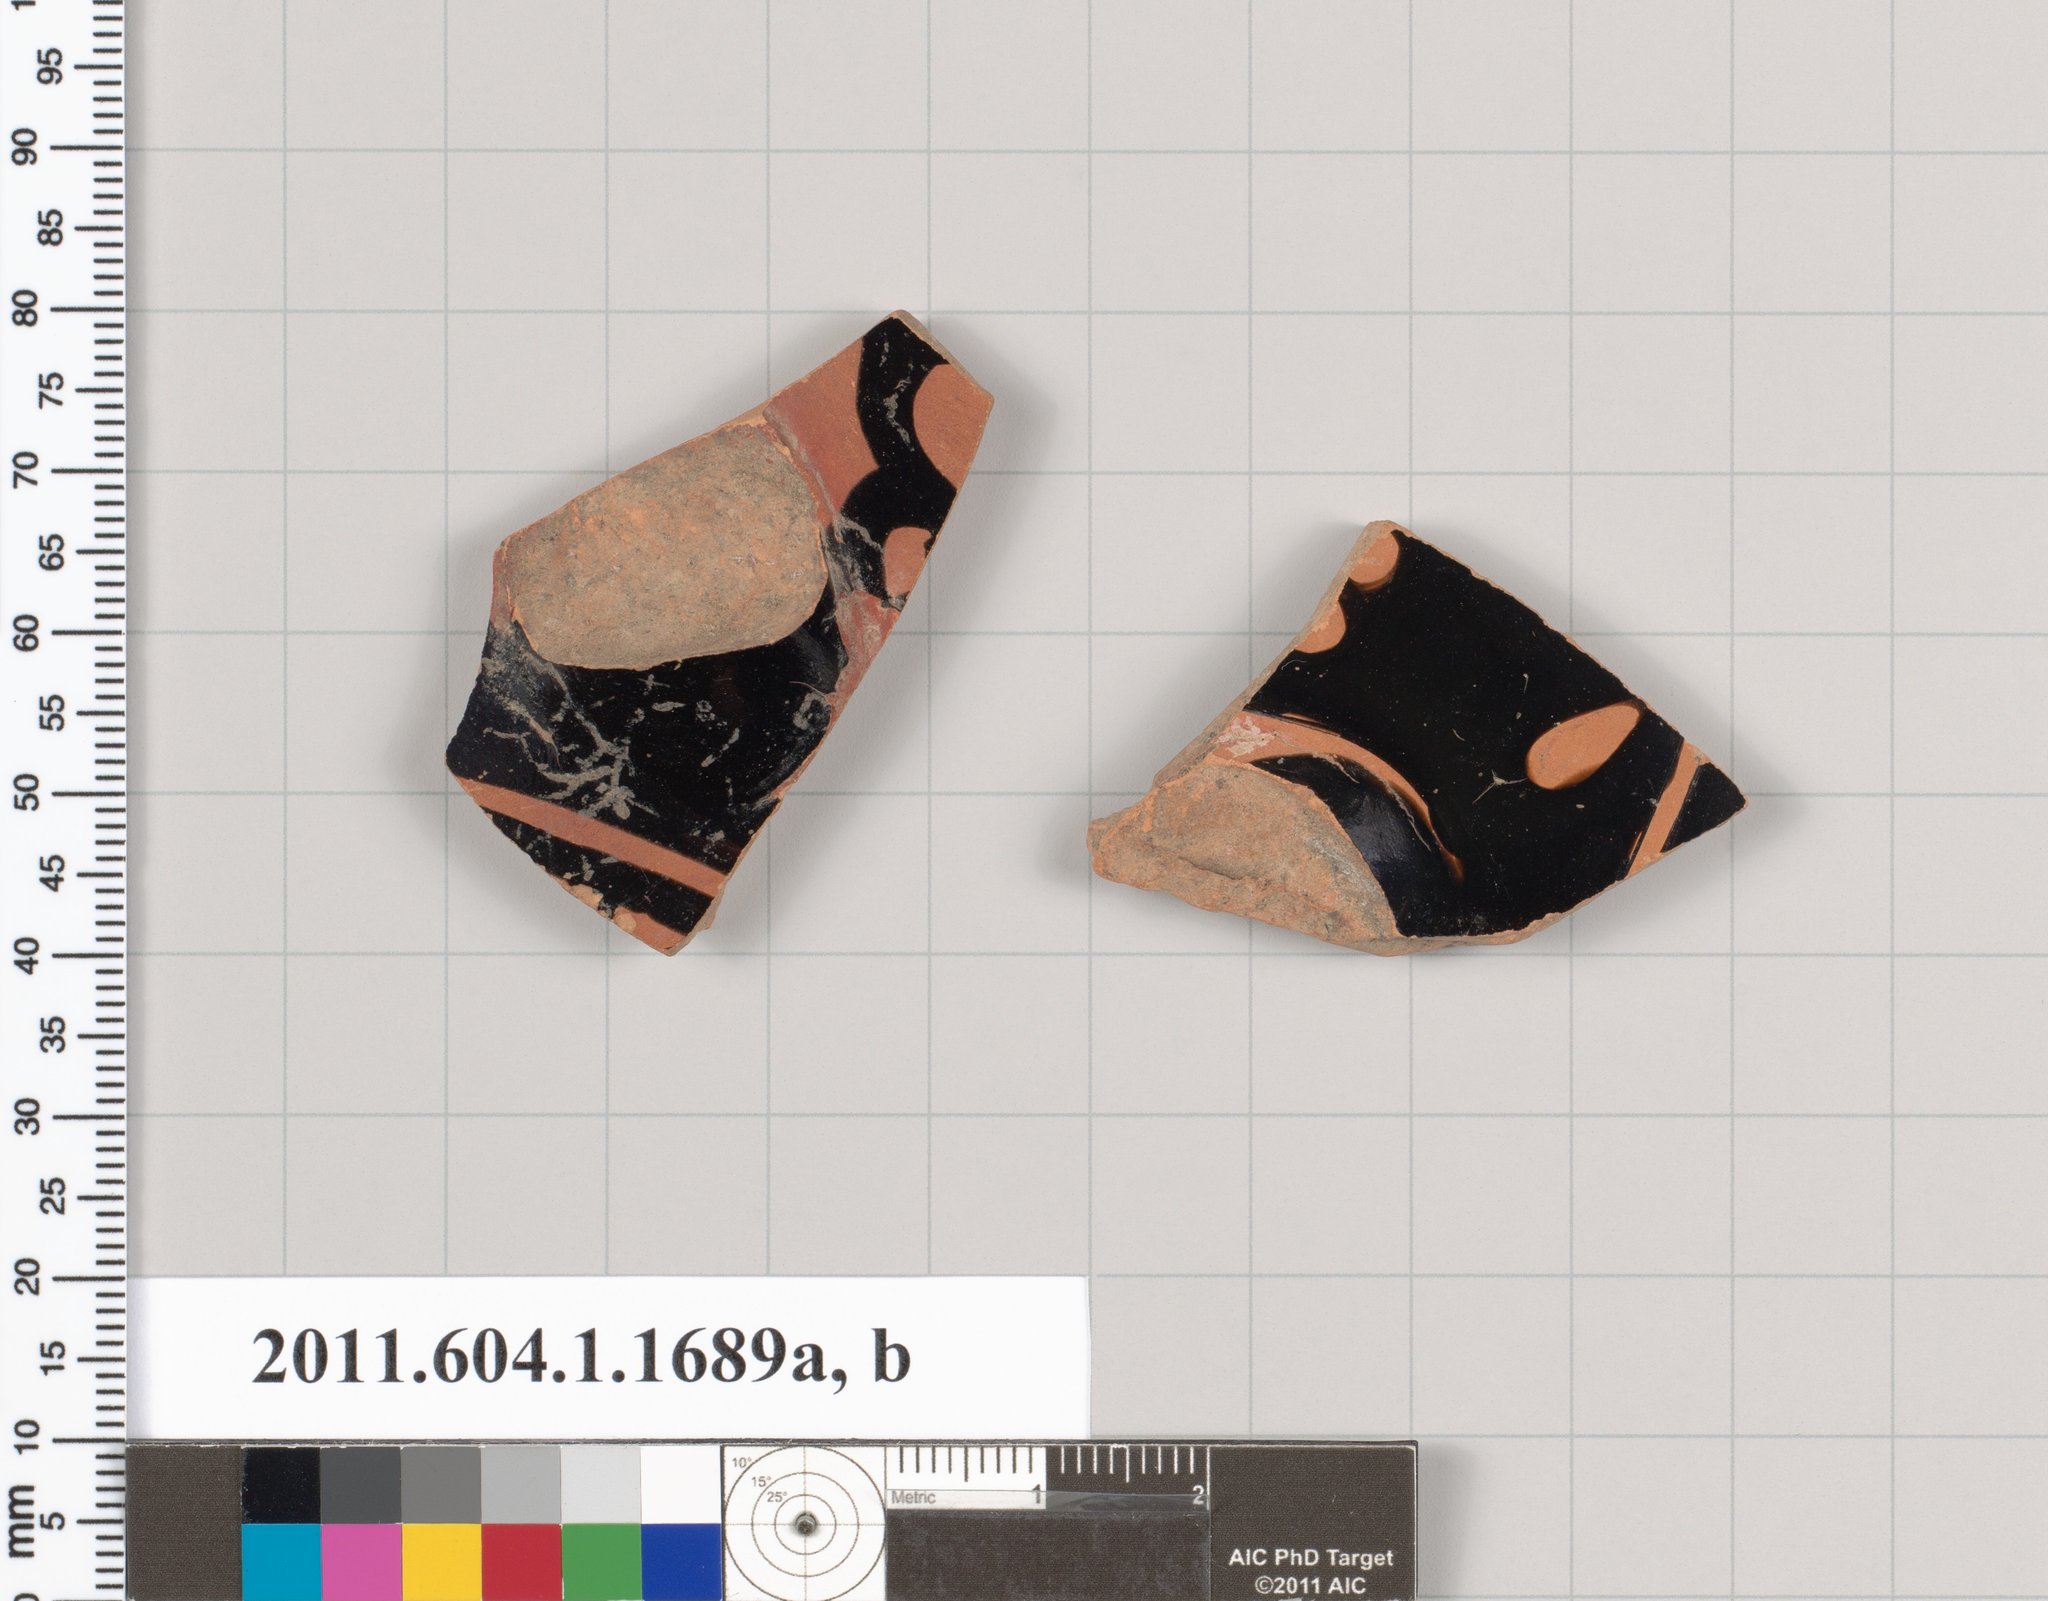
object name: kylix fragment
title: Terracotta fragments of kylikes (drinking cups)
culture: greek, attic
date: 500-401 BCE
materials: terracotta